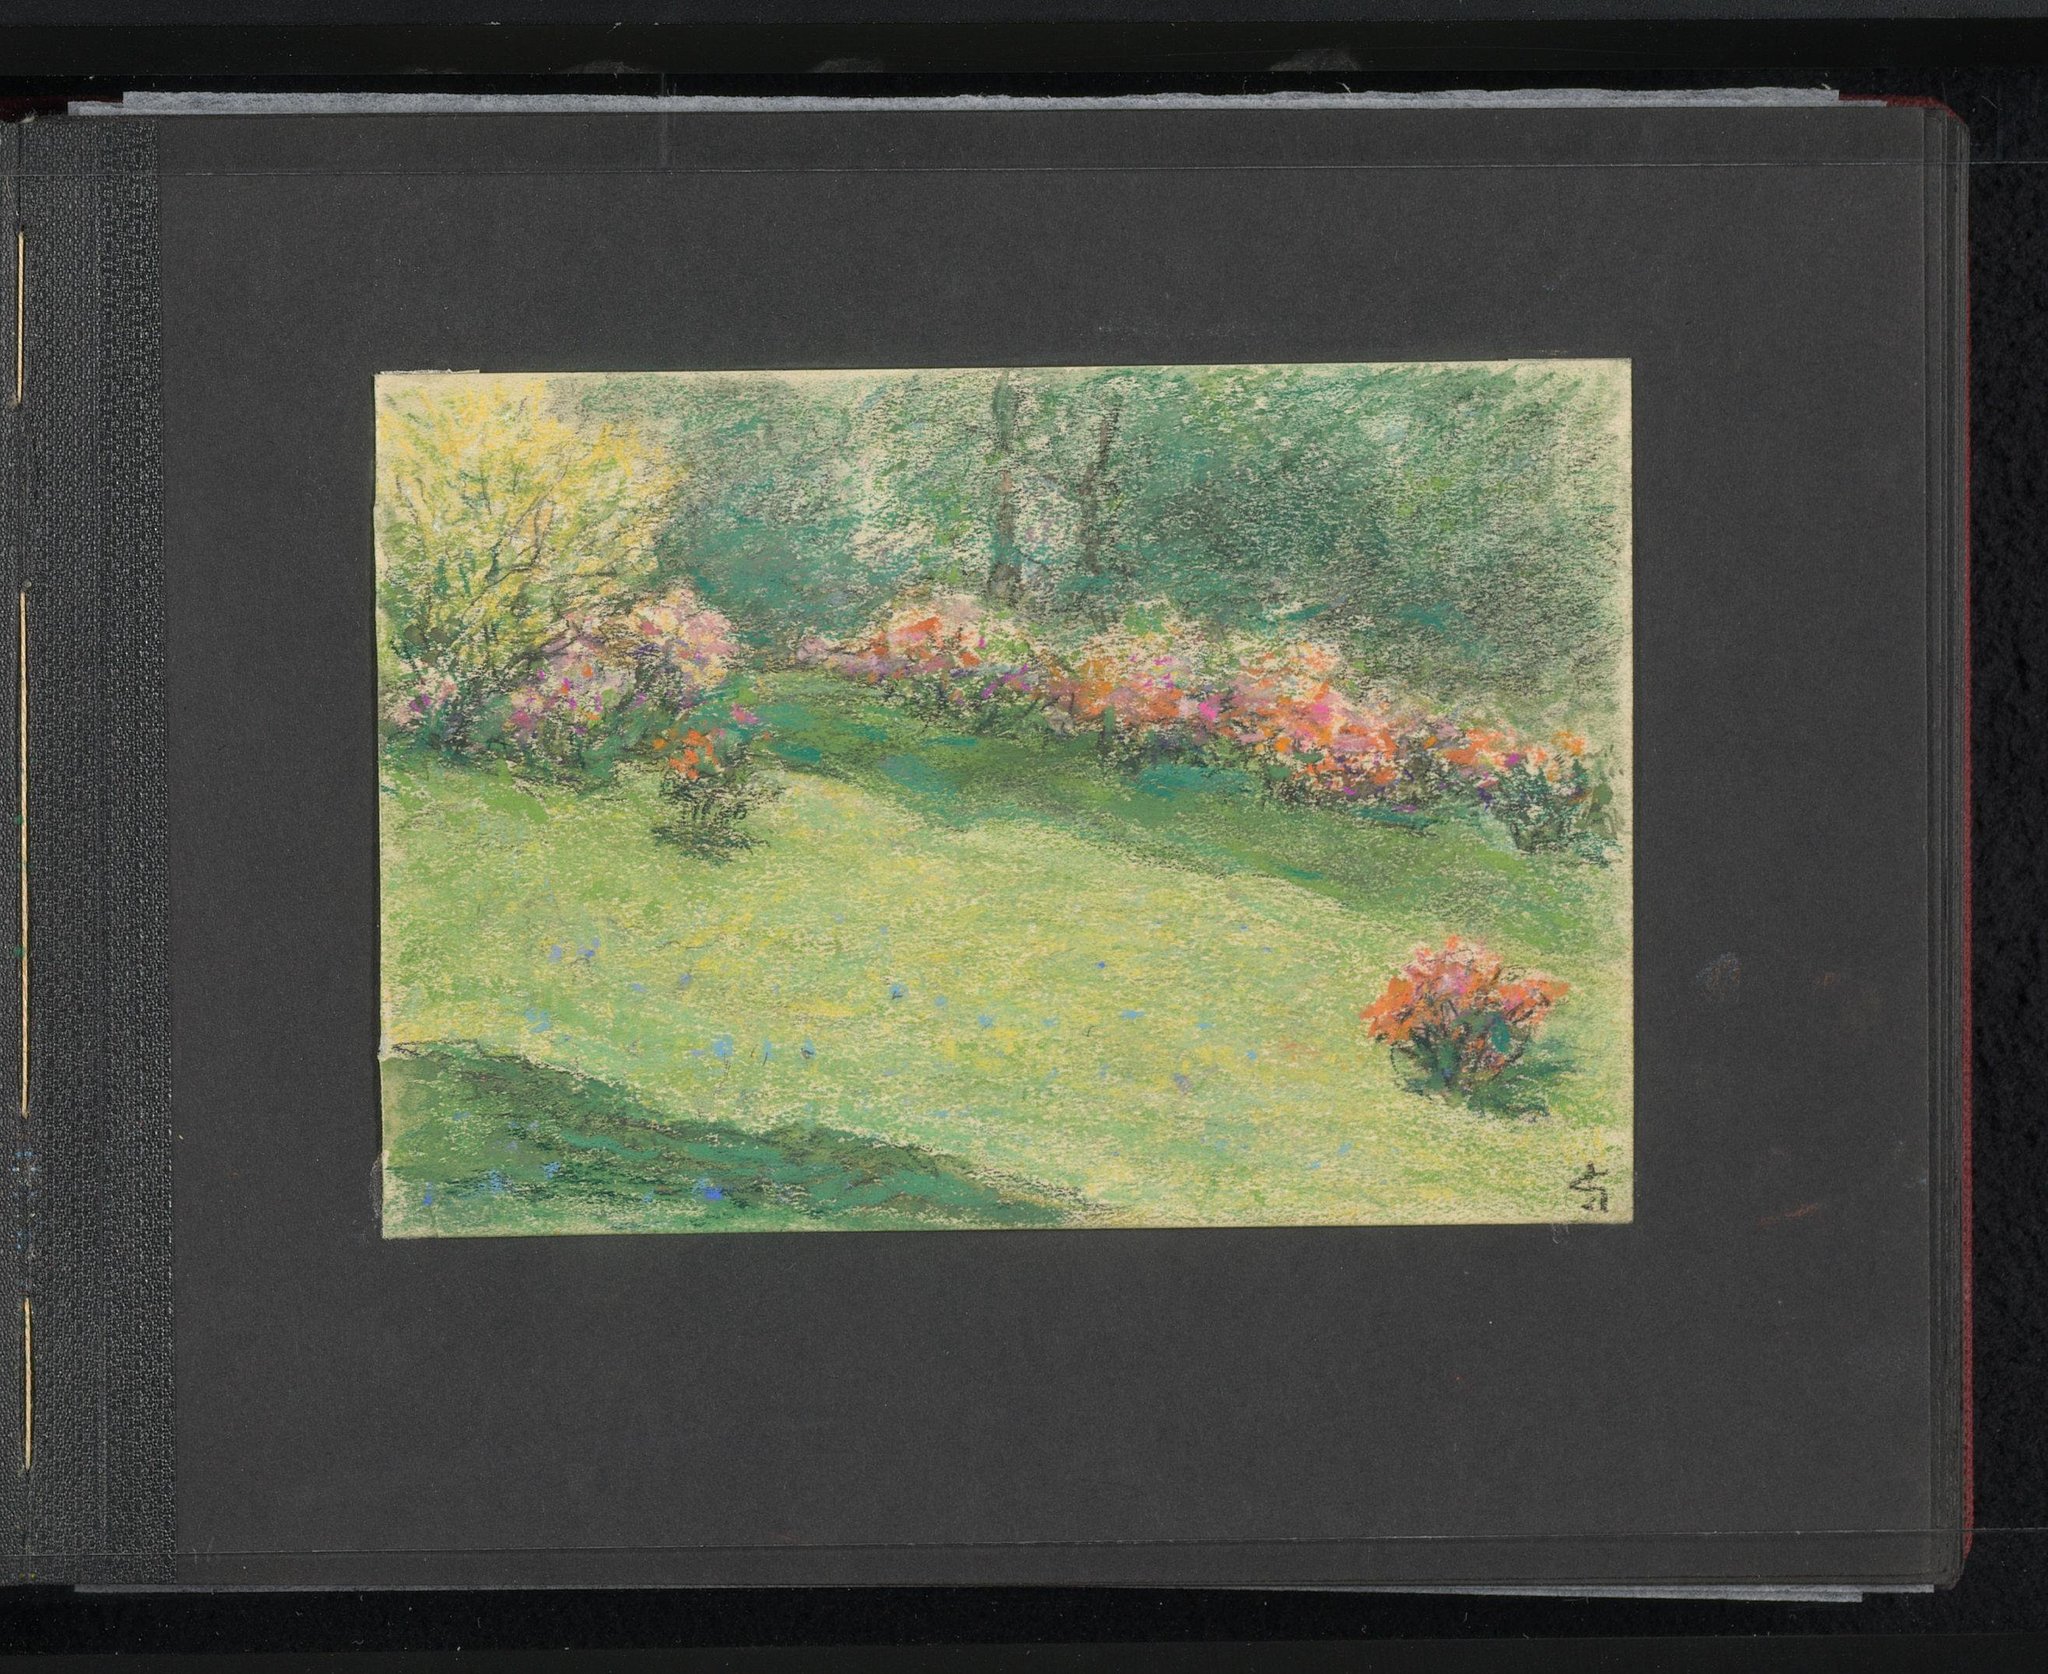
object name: drawing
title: Park met bloemen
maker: carel nicolaas storm van s-gravesande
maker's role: draughtsman, print maker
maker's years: 1841-1924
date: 1915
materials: chalk, paper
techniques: pasting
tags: flowers, public gardens, park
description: Mogelijk te Wiesbaden. Tekening maakt deel uit van een album.